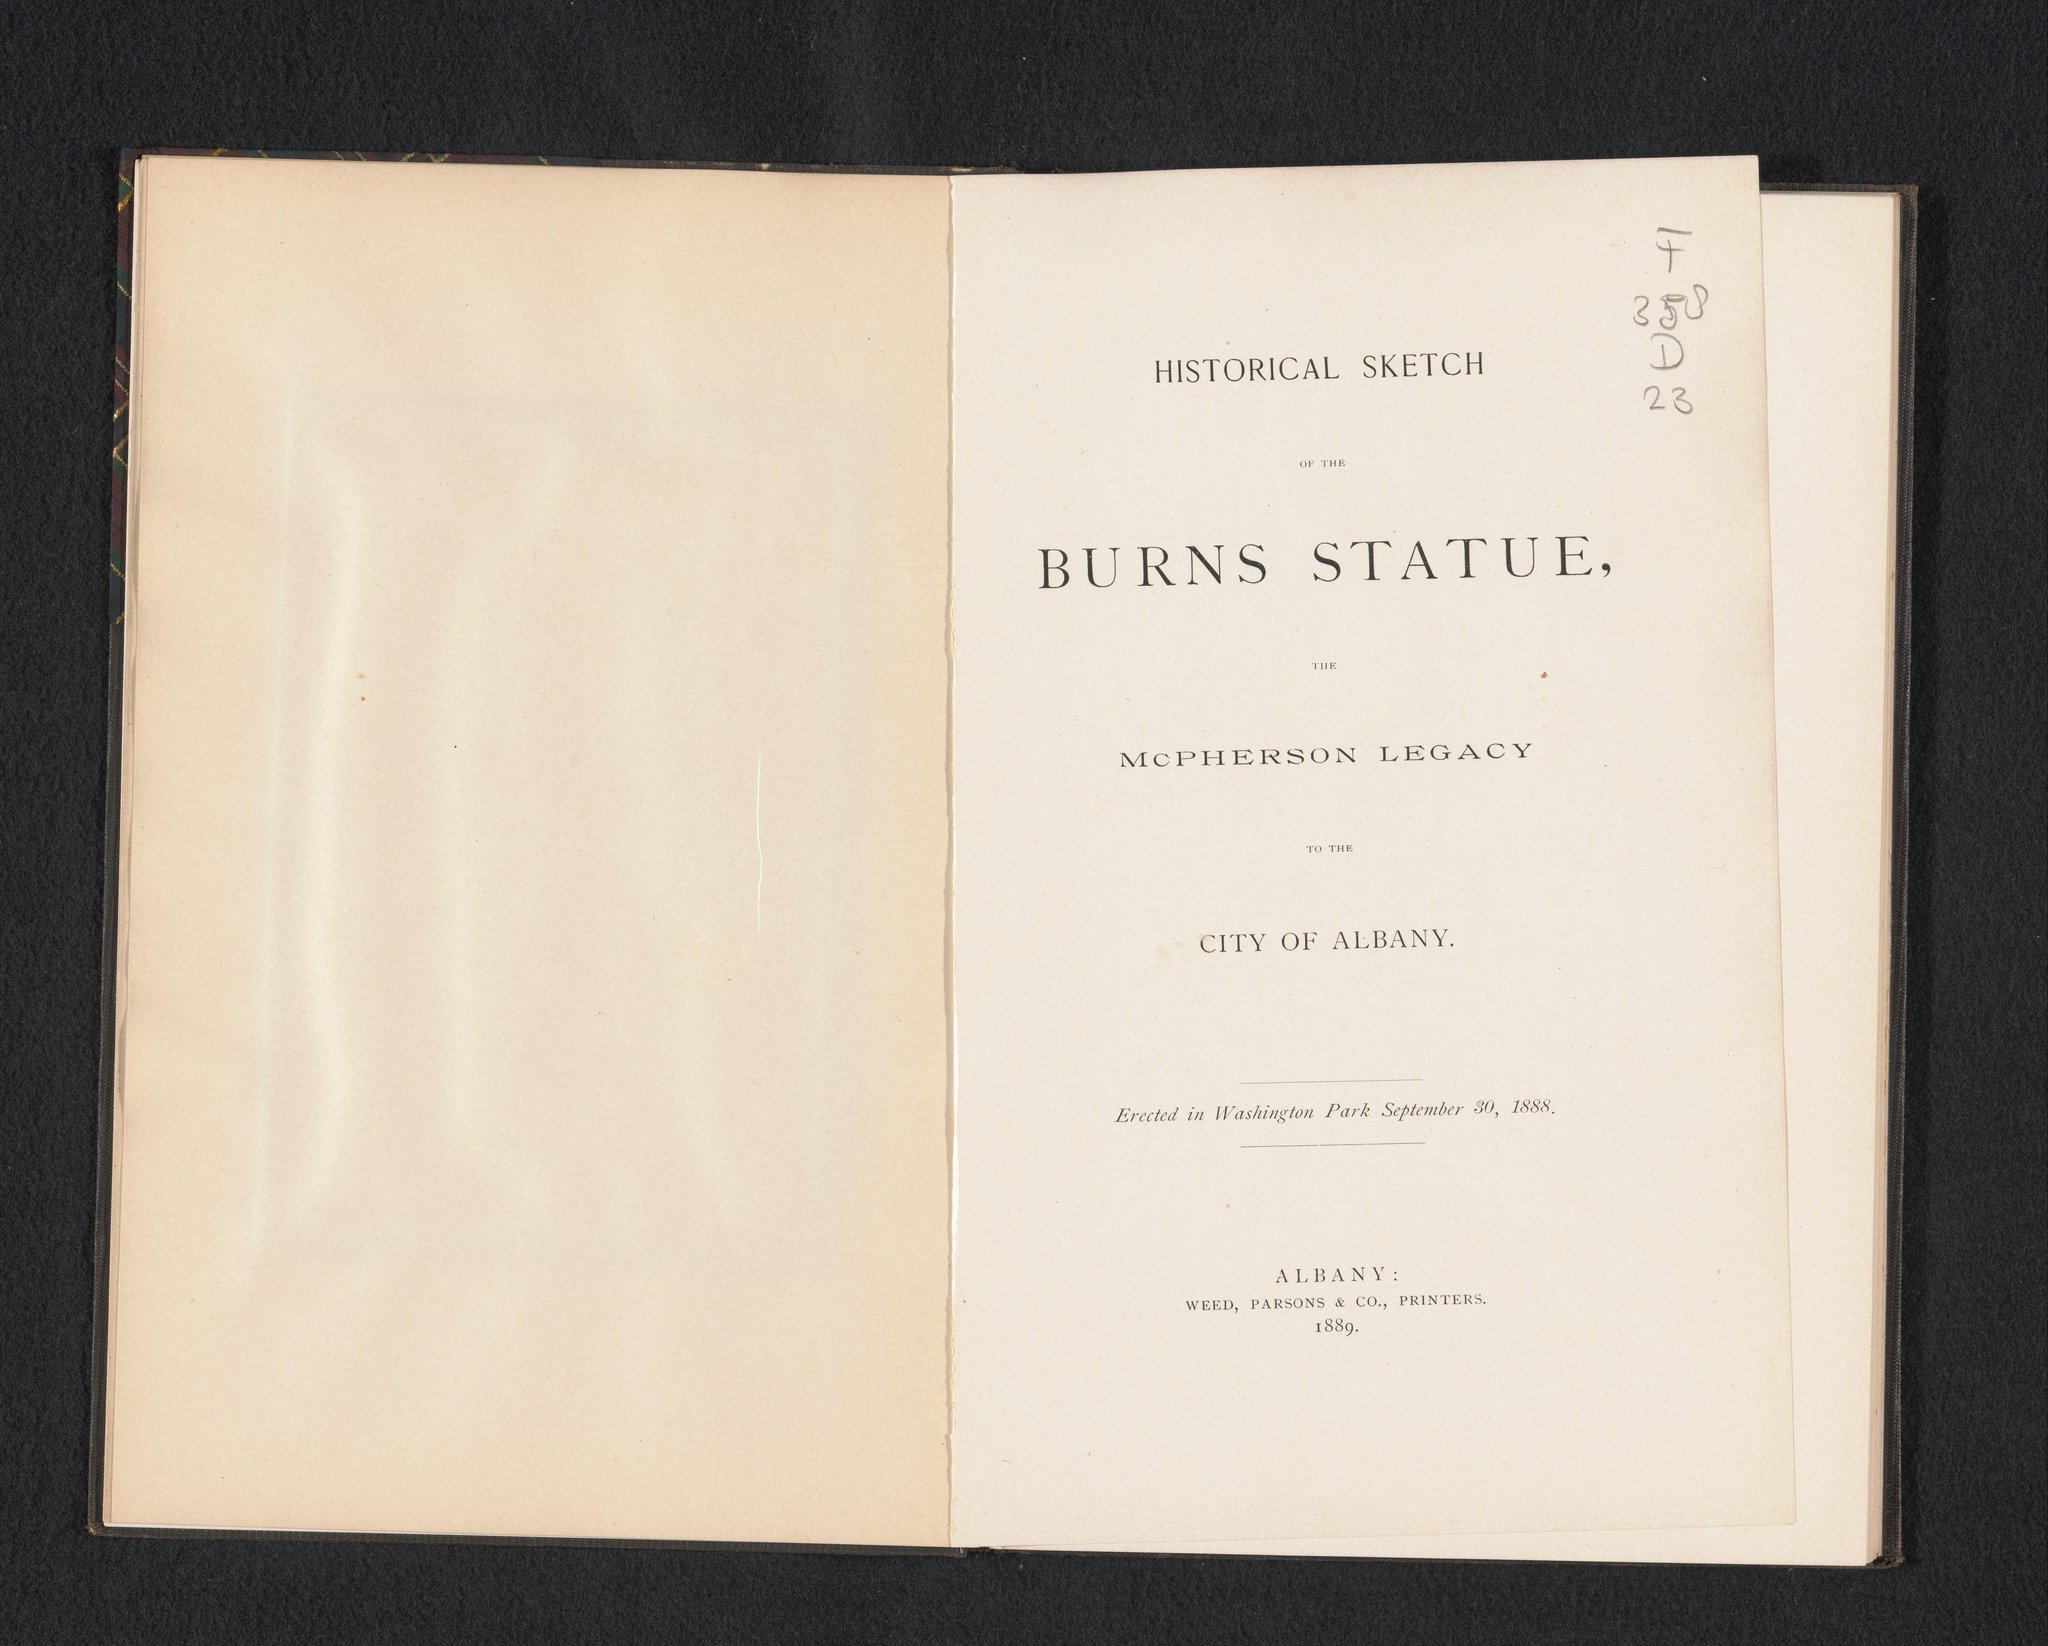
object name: book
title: Historical sketch of the Burns statue, the McPhersons legacy to the City of Albany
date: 1889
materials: cardboard, linen, paper, photographic support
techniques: albumen print, printing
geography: albany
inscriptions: inscription: ‘With Compliments of Peter Ki[...]’